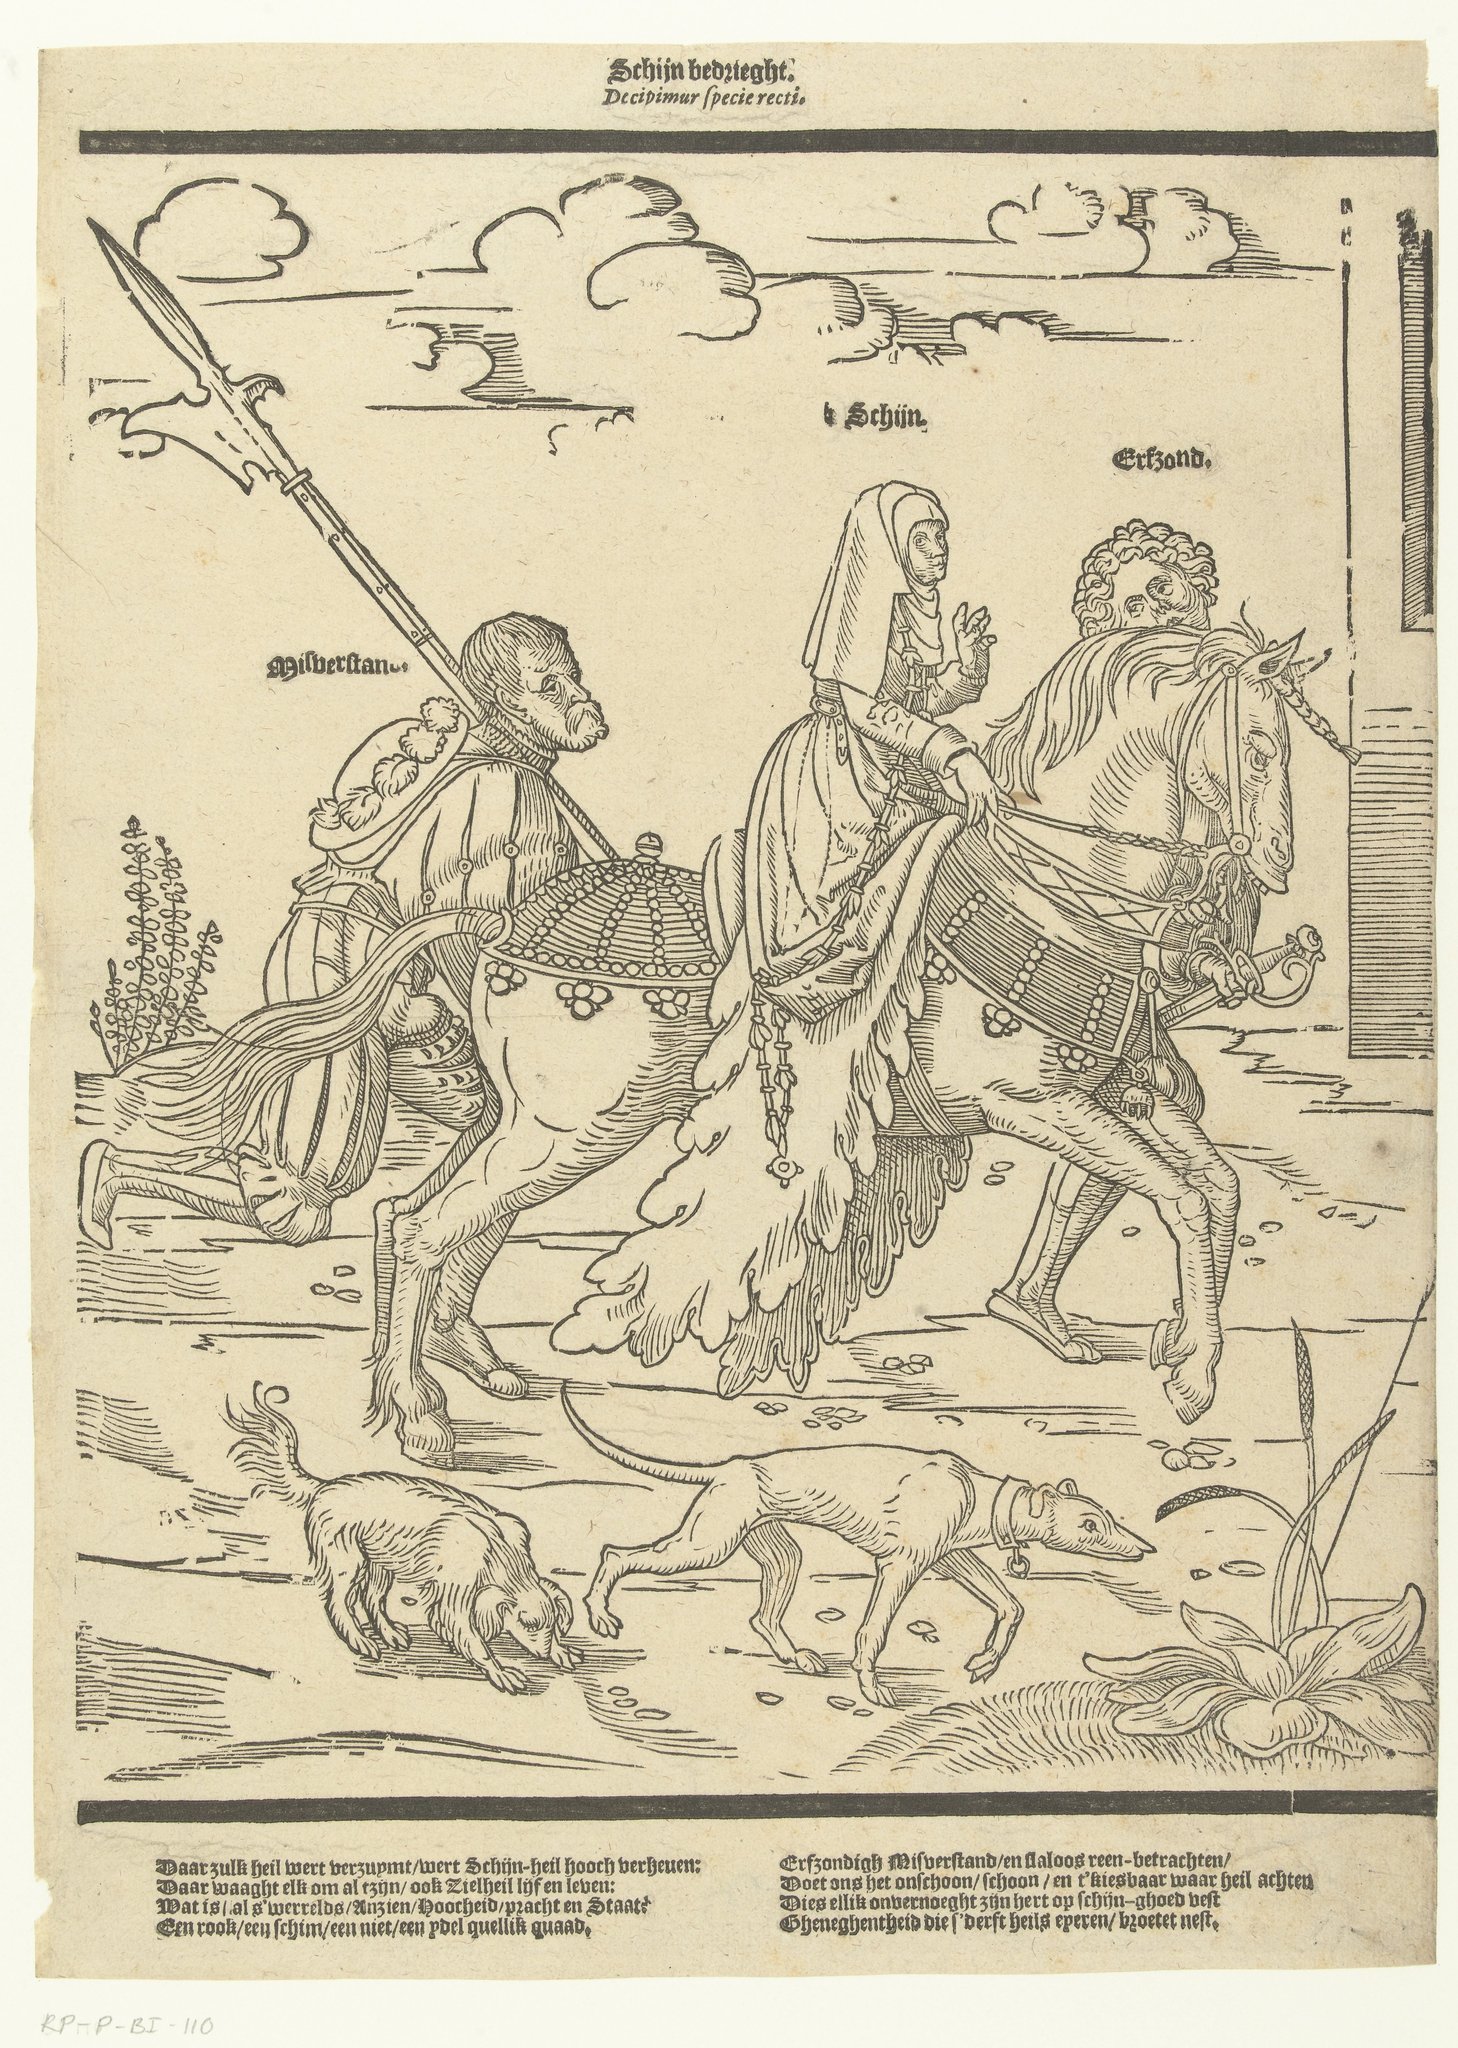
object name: print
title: Verderf-traps beeld-schrift ofte heiligh letteren dat is. Hieroglifica.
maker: Anonymous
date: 1520-1560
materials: paper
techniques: woodcut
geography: low countries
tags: riding a horse, ass, or mule; rider, horseman, proverbs, sayings, etc.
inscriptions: collector's mark: Lugt 2228a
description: Eén van acht moraliserende spreuken. Schijn te paard met Misverstand en Erfzond als voetknechten. Tekst onder prent